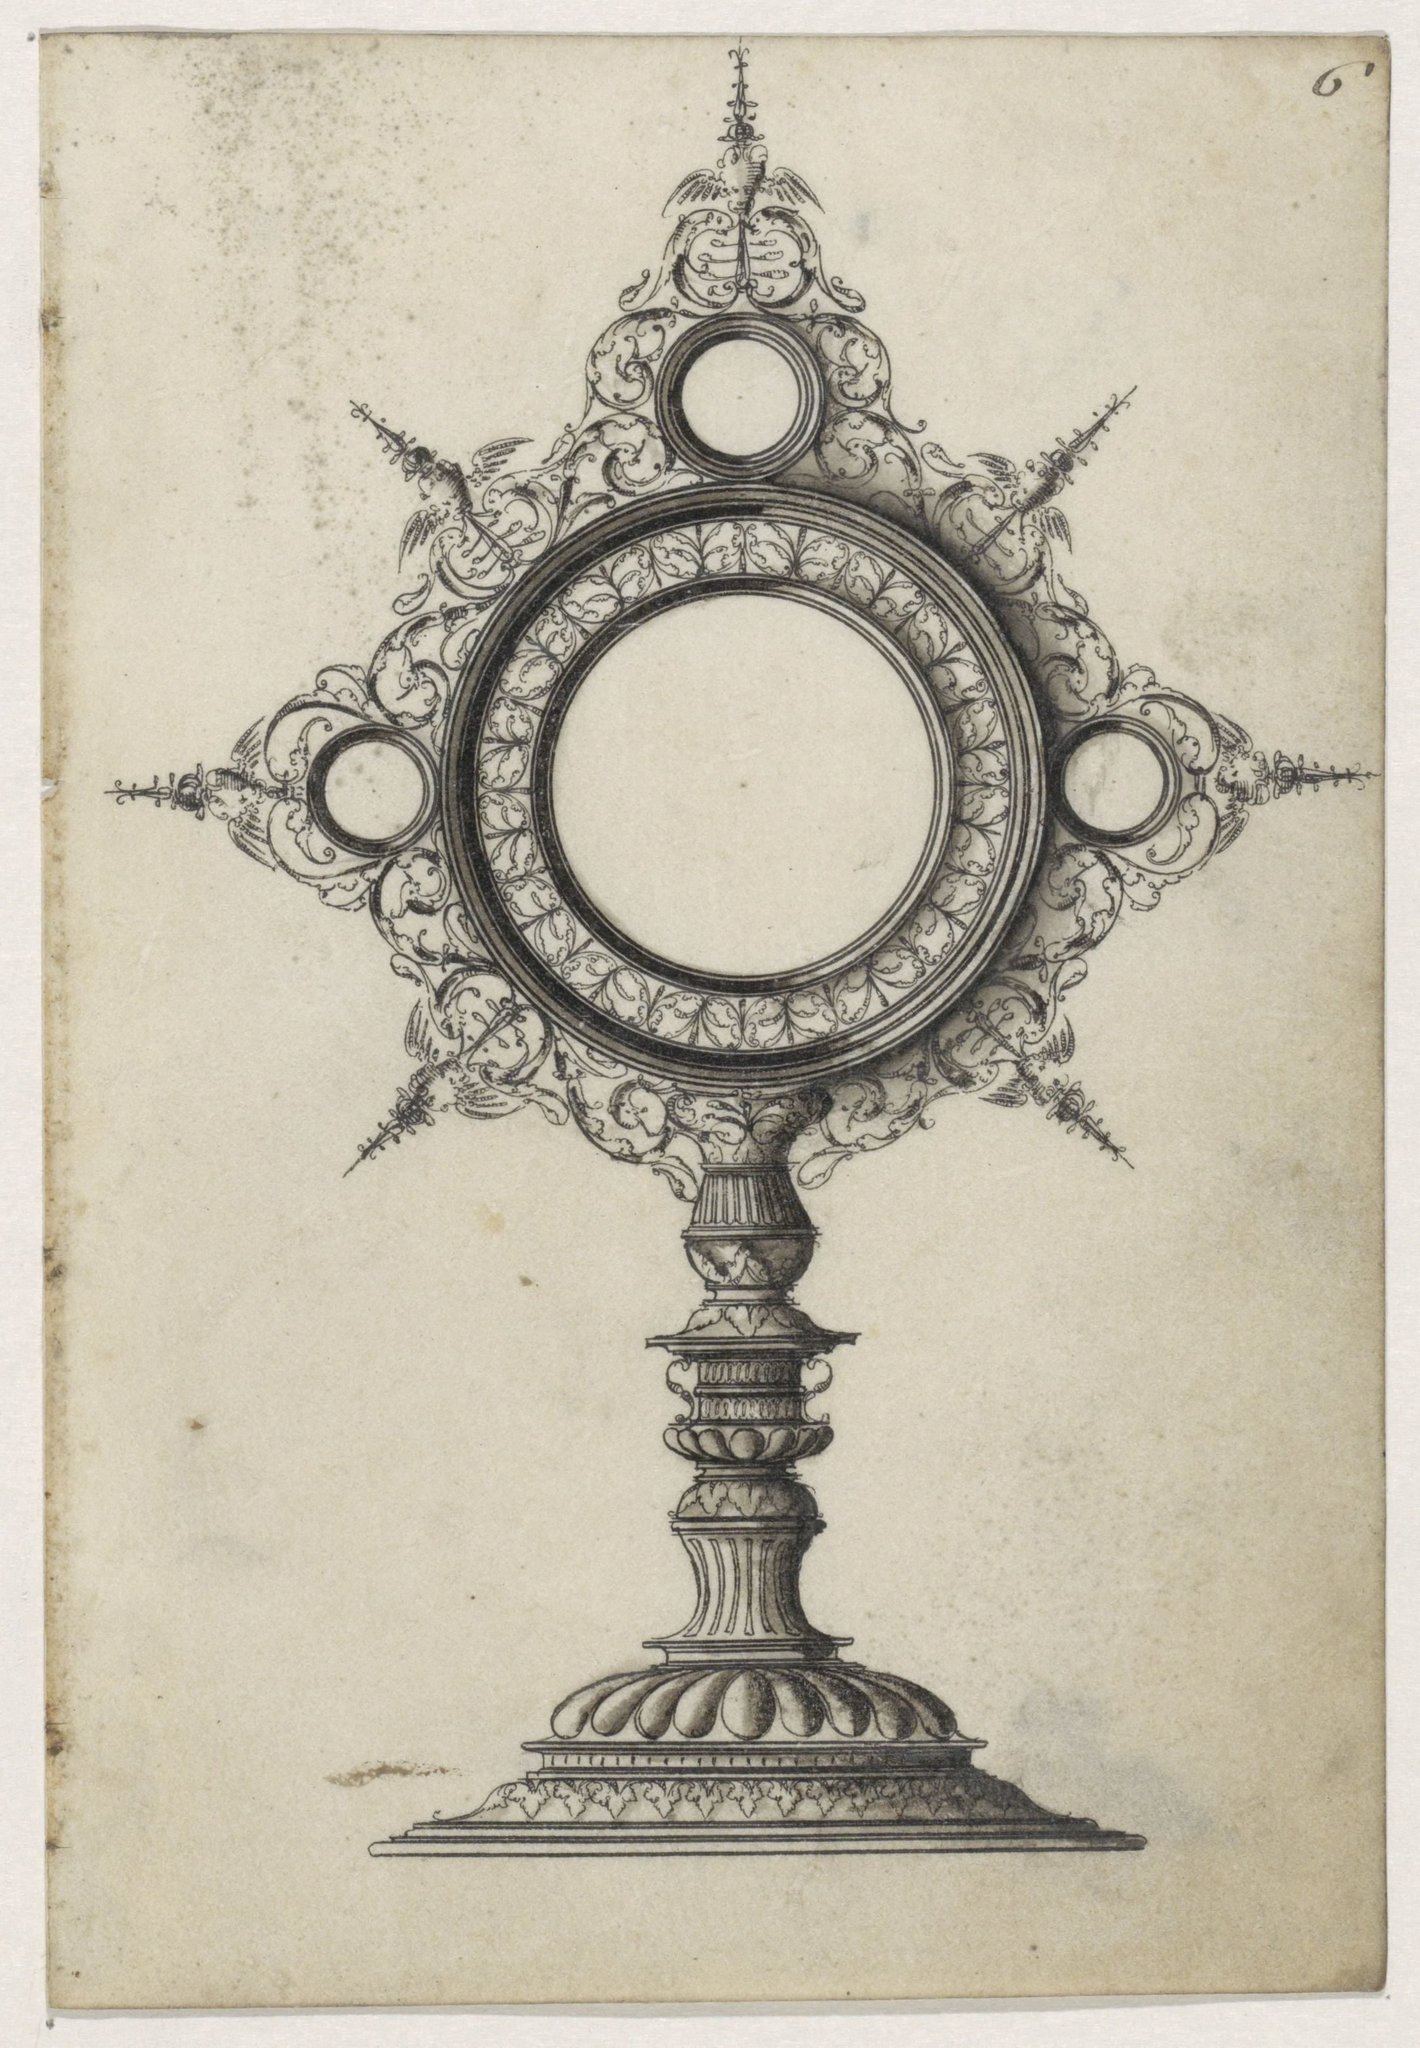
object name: album leaf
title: Monstrans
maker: jacques androuet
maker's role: draughtsman, print maker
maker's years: 1515-1584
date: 1543-1553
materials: ink, parchment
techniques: brush, pen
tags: ostensorium, monstrance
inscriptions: number: ‘6’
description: Blad 6 recto, los opgezet blad uit een album bestaande uit een band met twee bladen, een schutblad en zeventien apart opgezette bladen.